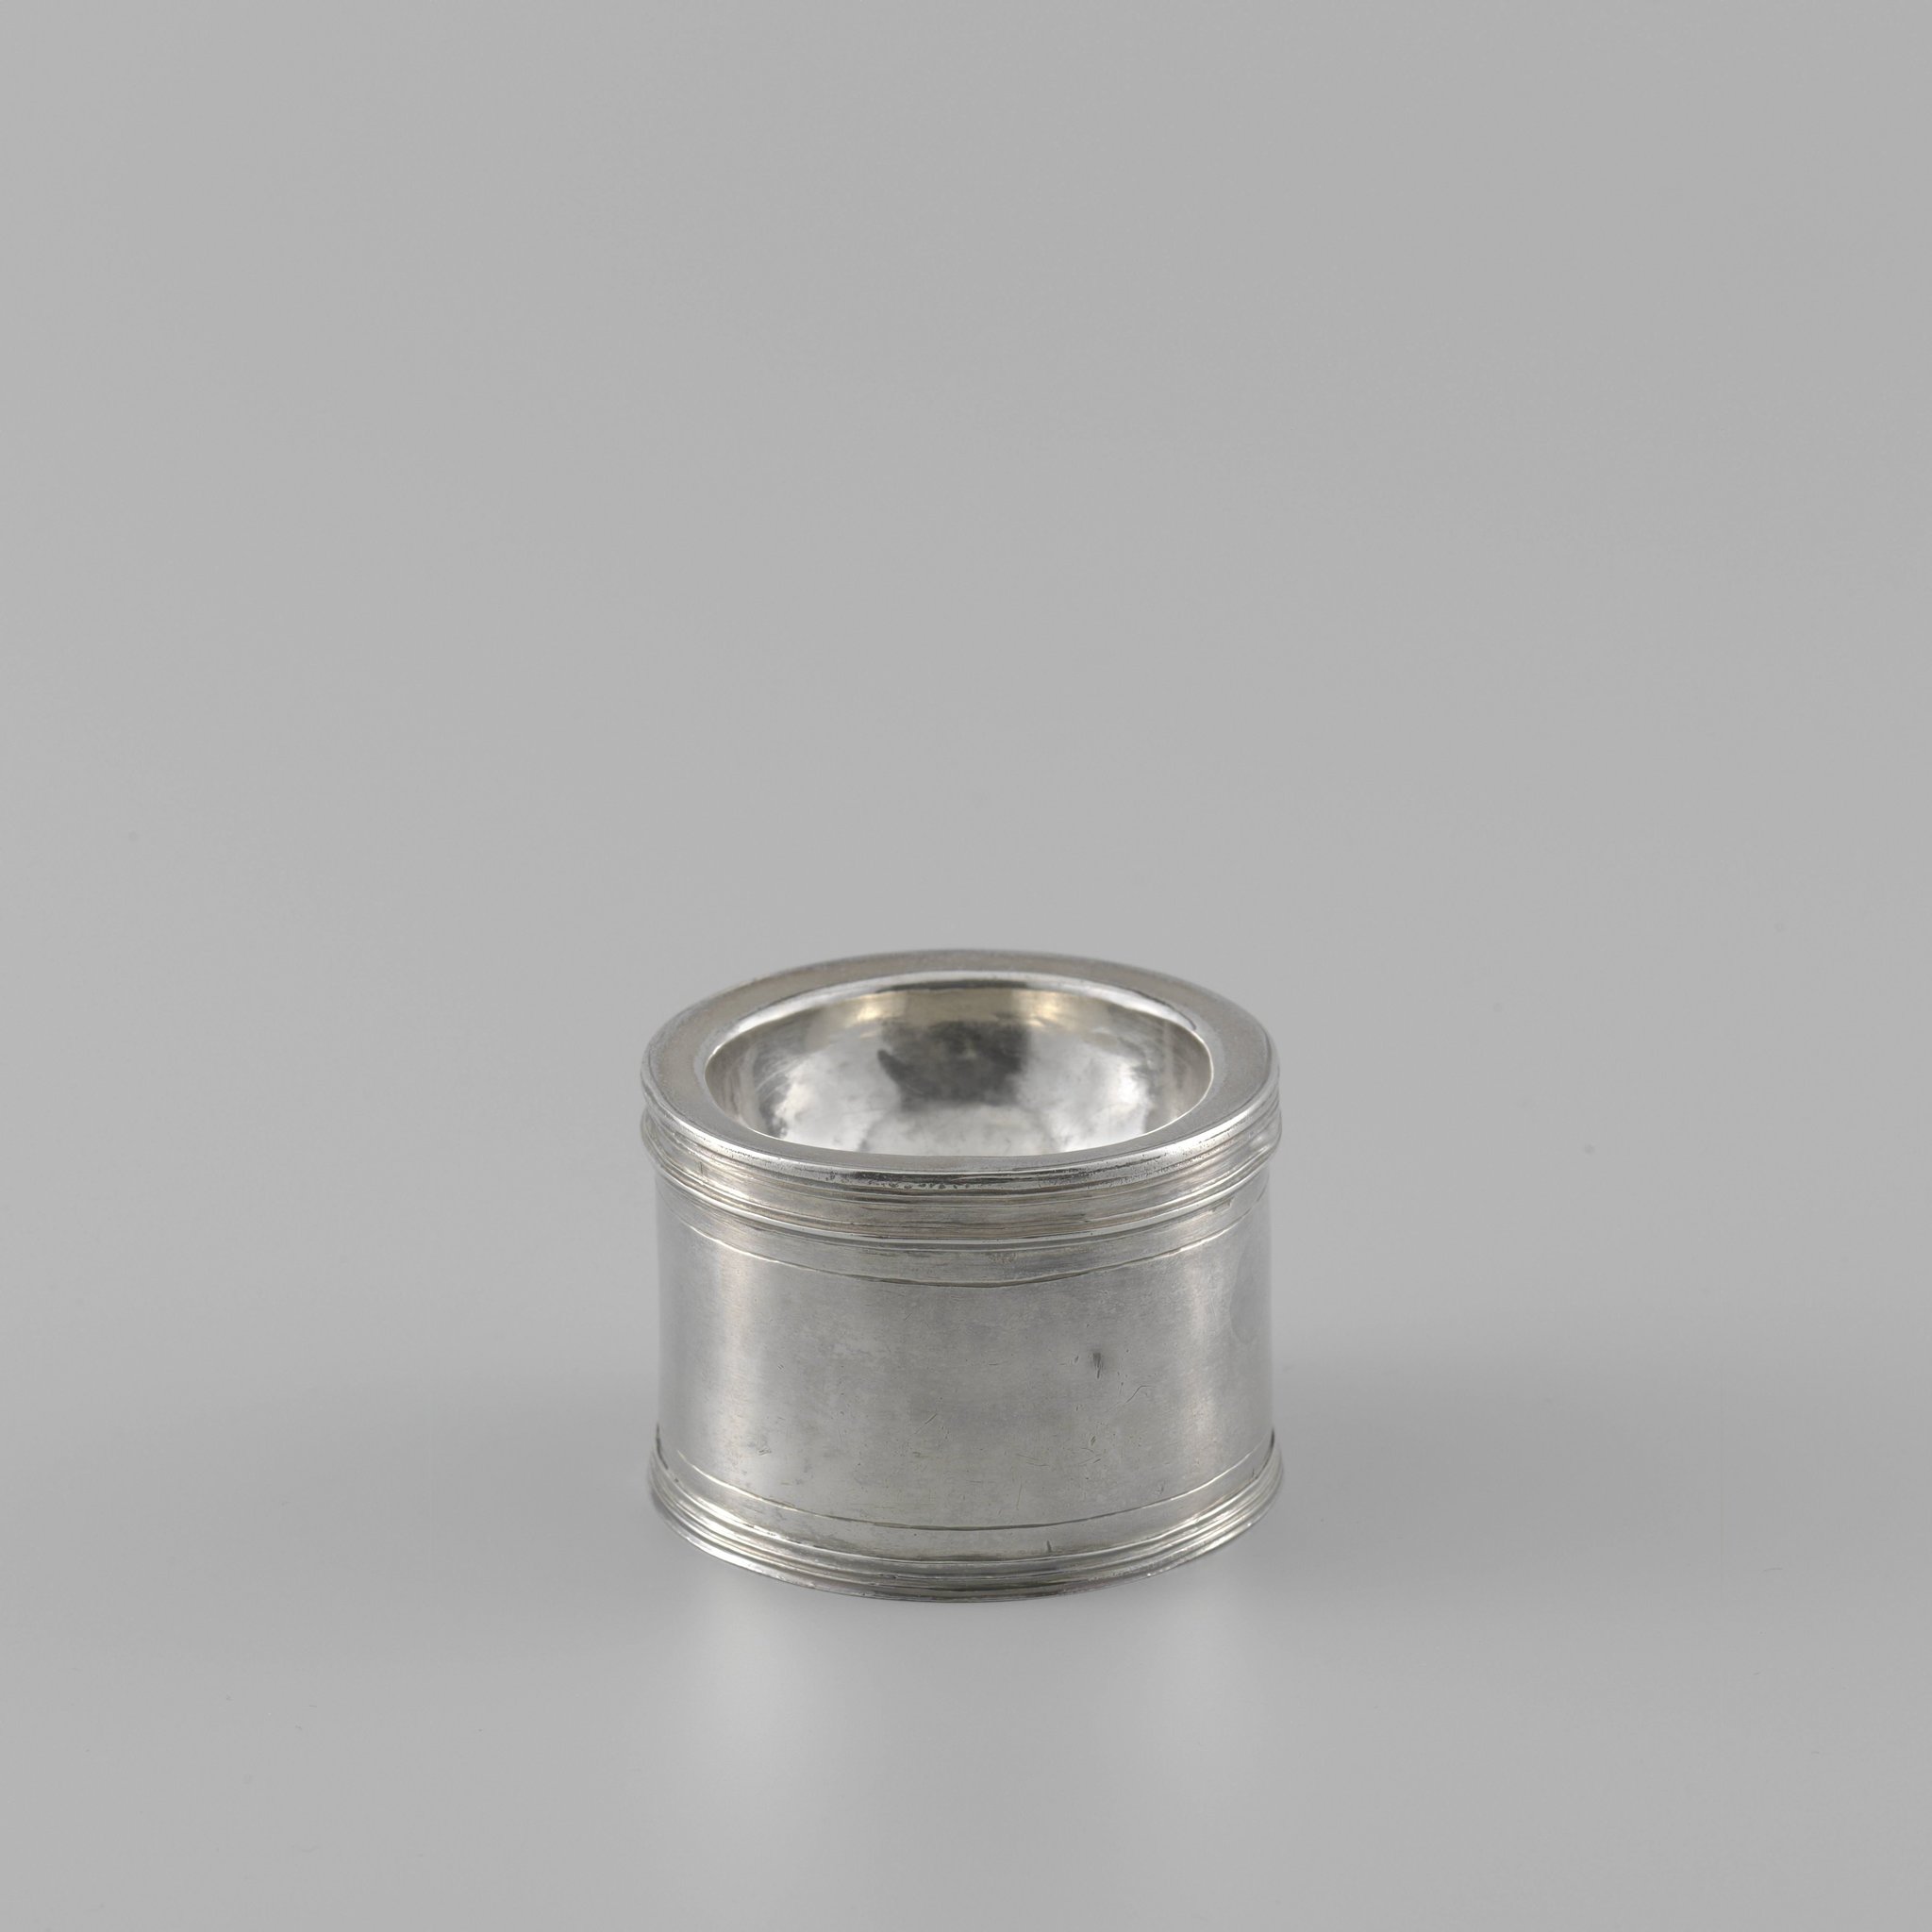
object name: kruidendoos, specerijdoos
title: Deel van een gecombineerd zoutvat-specerijdoos met deksel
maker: Anonymous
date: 1622-1632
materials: silver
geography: flushing